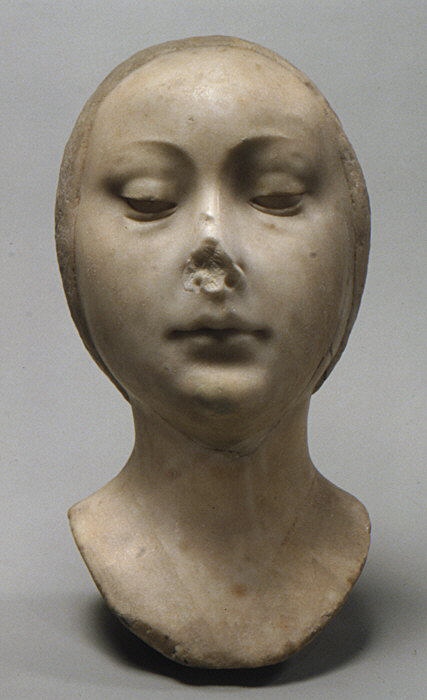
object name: mask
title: Young Woman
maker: francesco laurana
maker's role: artist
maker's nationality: italian, born croatia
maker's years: 1415-1507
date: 1475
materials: marble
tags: masks,portraits,women